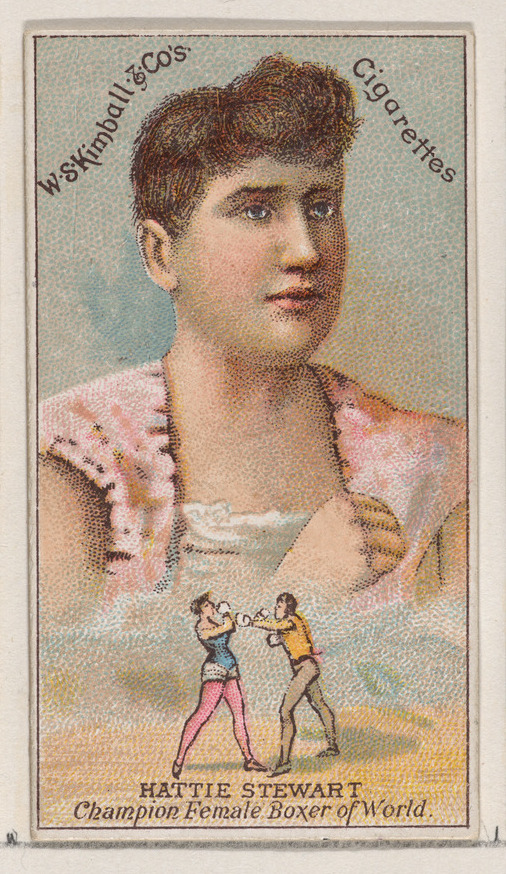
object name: print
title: Hattie Stewart, Champion Female Boxer of the World, from the Champions of Games and Sports series (N184, Type 1) issued by W.S. Kimball & Co.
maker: w.s. kimball & co.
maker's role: publisher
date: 1887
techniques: color lithograph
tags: women,boxing,athletes